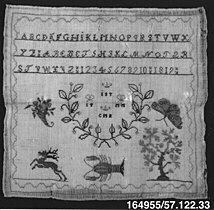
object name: sampler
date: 1801-1900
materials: canvas, silk, wool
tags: deer,butterflies,trees